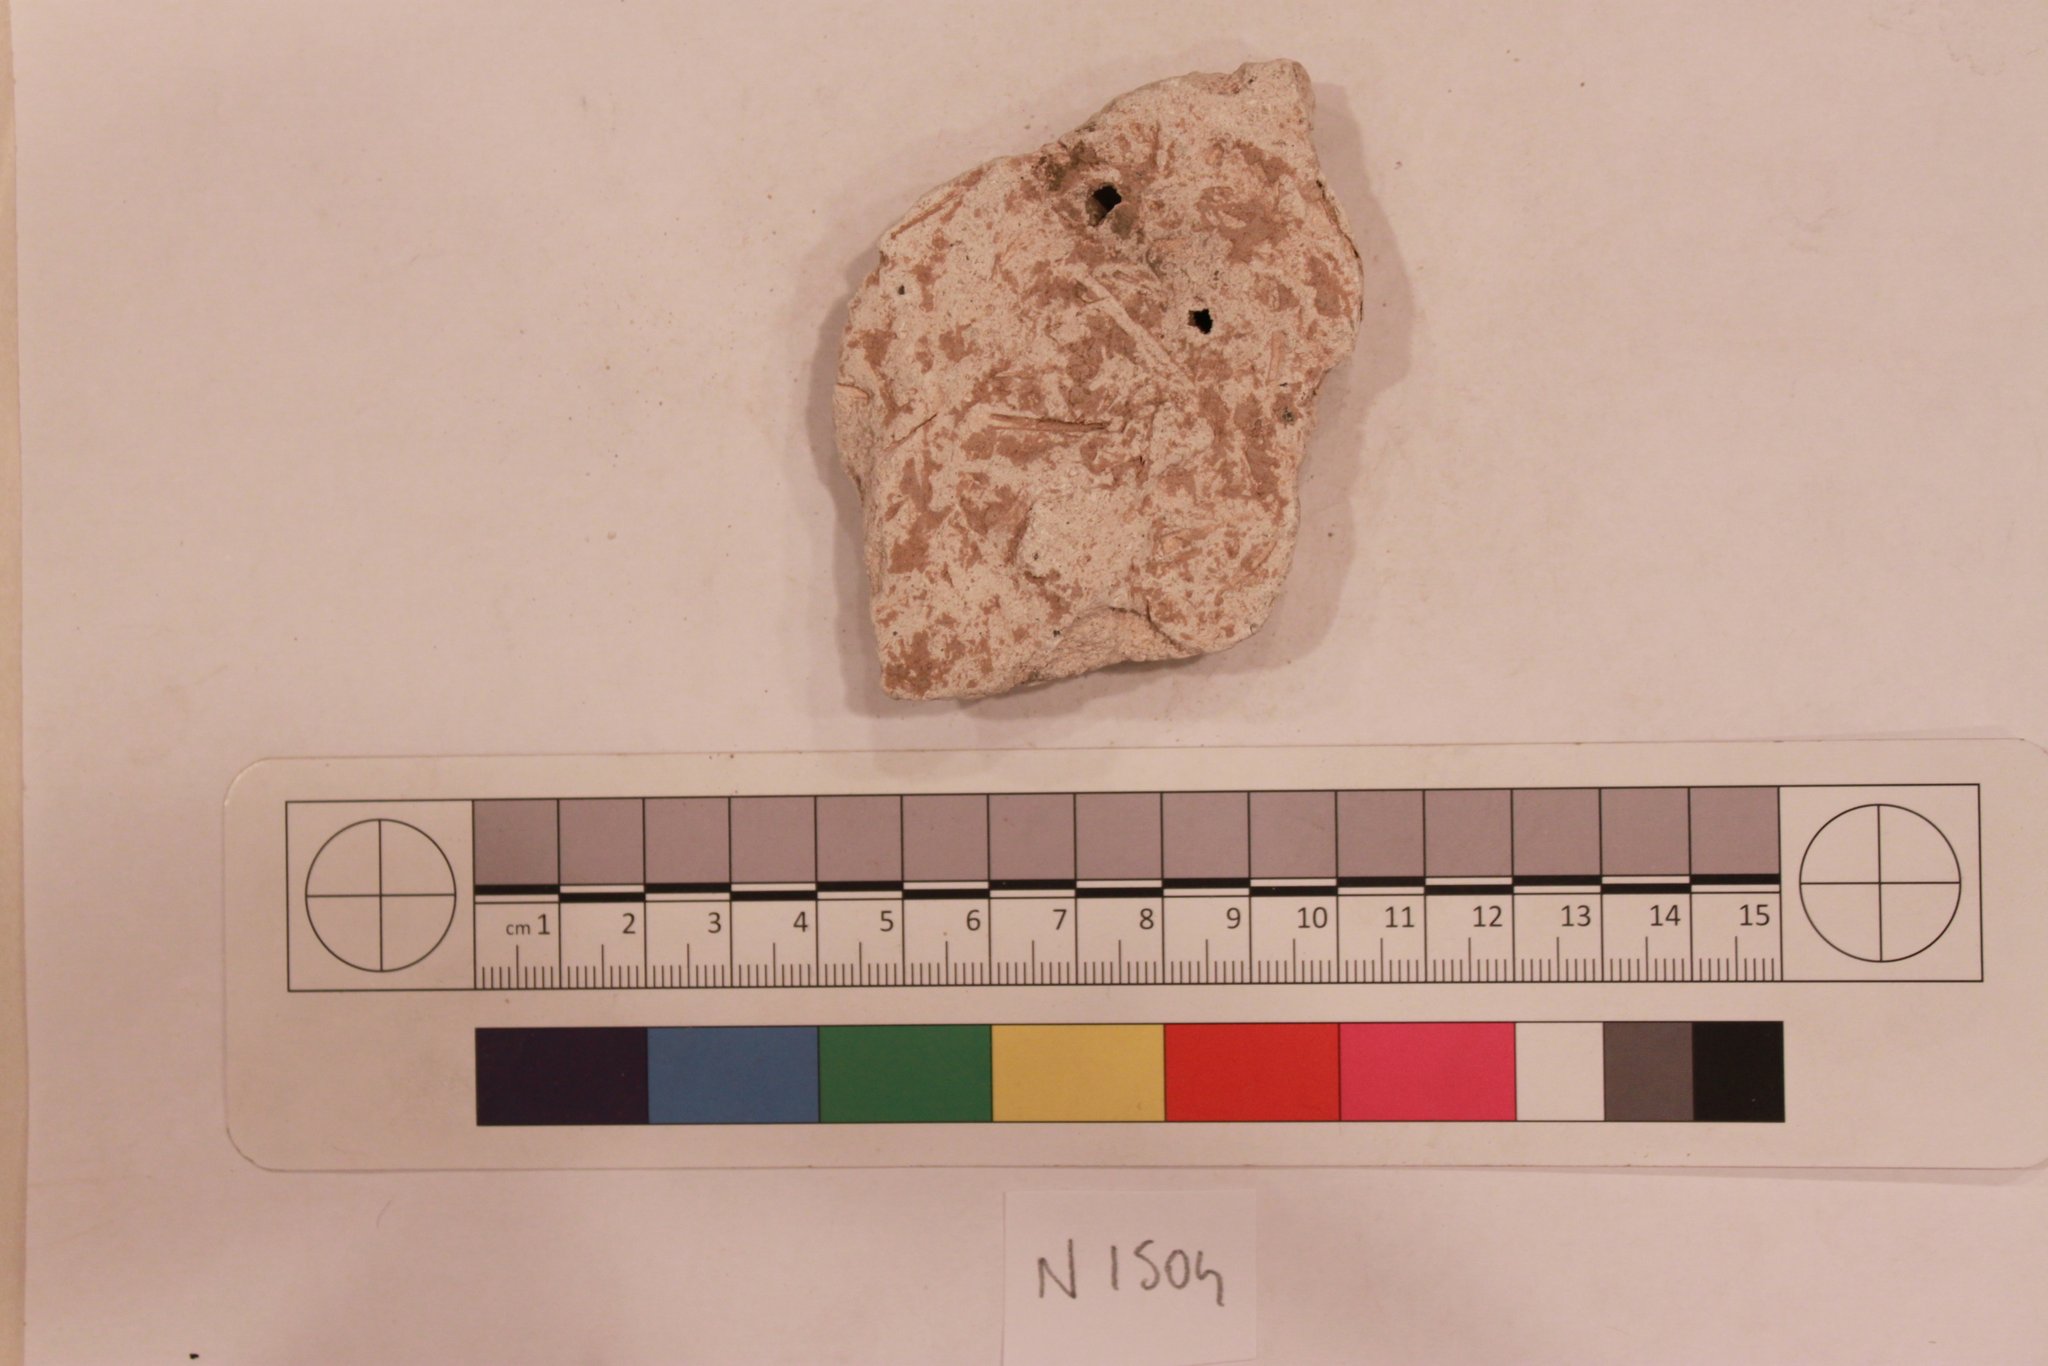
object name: fragment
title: Stucco Fragment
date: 701-1200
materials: plaster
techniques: carving, painting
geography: iran